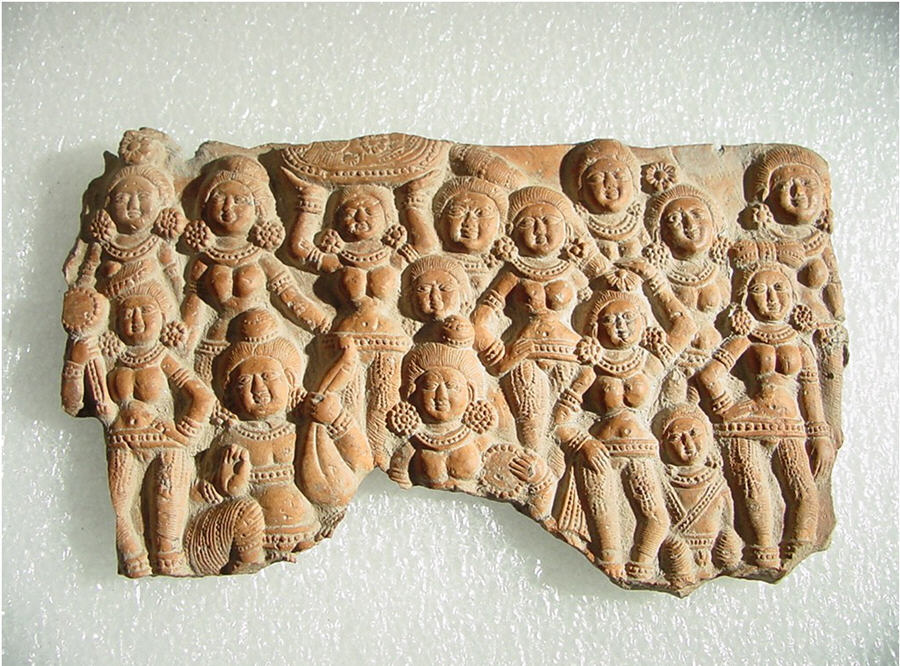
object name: plaque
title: Fragmentary Plaque with a Crowd of Onlookers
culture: india, bengal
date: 1-100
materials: terracotta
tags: women,crowd